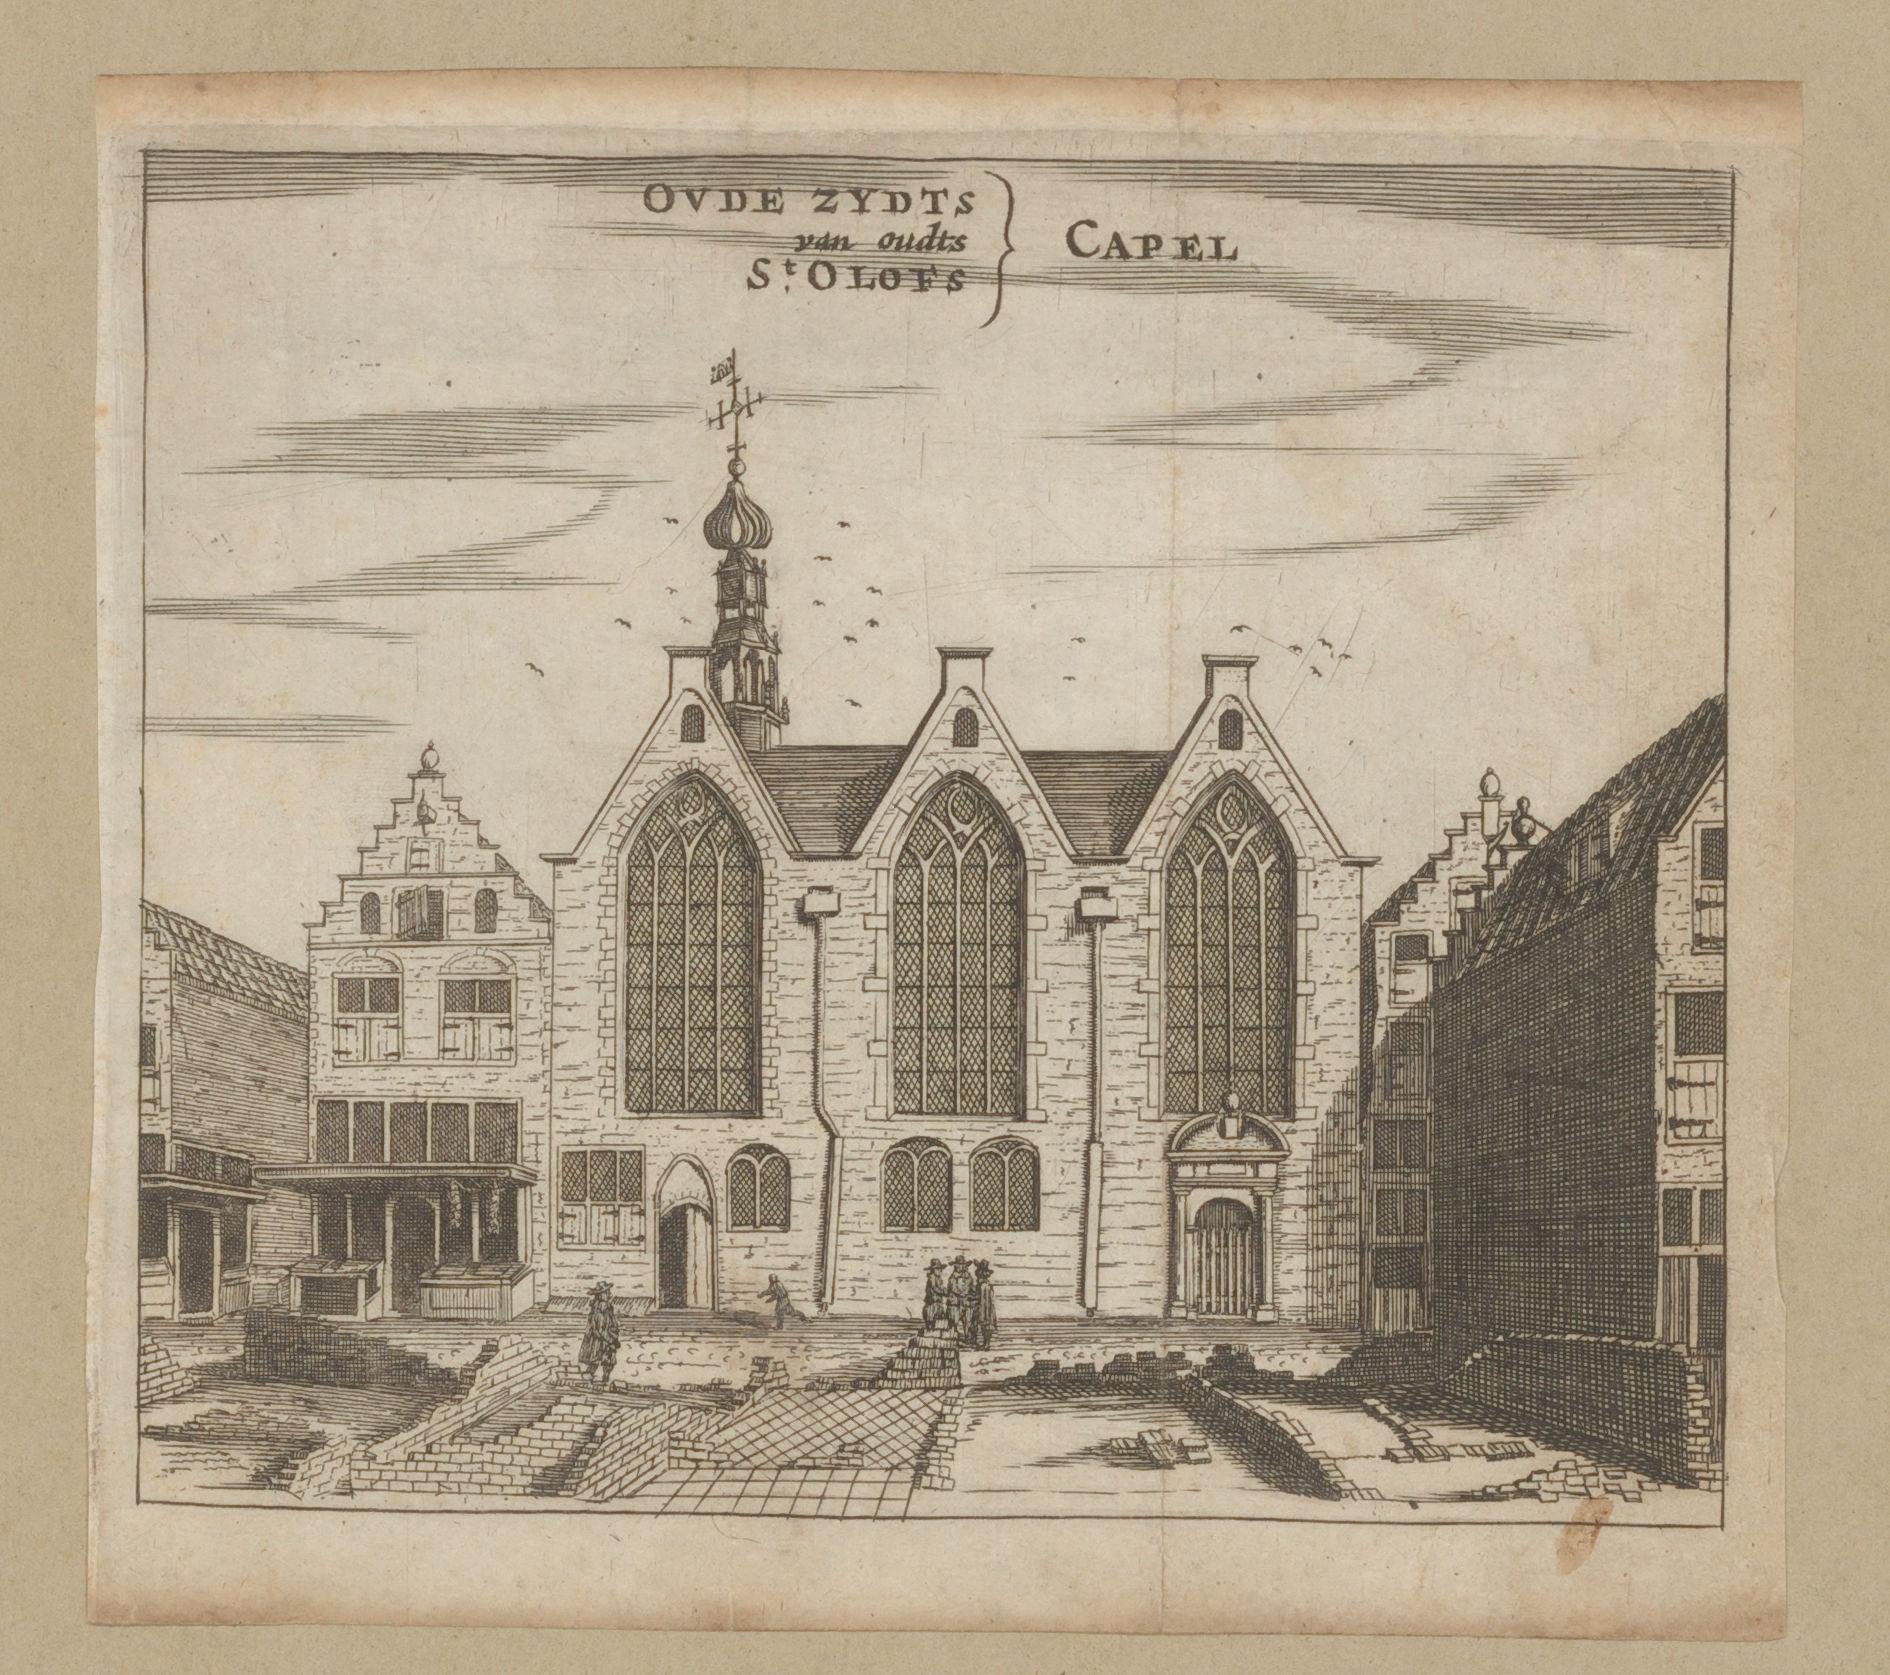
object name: book illustration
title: Oude Zydts van oudts St. Olofs Capel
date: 1664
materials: paper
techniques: engraving, etching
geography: amsterdam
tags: church (exterior) - qq - small church, chapel, street (+ city(-scape) with figures, staffage)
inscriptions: collector's mark: ‘32.3A+B’ Lugt 1641b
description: Huidige staat van prent ook gebruikt in: Fockens, Melchior. Beschrijving Der wijdt-vermaarde Koop-stadt Amstelredam, Van haar eerste beginselen, zedert den Jare 1203. oude Voorrechten, verscheyde Vergrootingenoude Voor-rechten, en verscheyde Vergrootingen (…). 3e druk. Amsterdam: Marcus Willemsz. Doornick, 1664. En in: Zesen, Philipp von. Beschrybung der Weidtberuhmde Kauf-Stadt Amstelredam / Beschreibung der Stadt Amsterdam darinnen von derselben ersten ursprunge bis auf gegenwartigen zustand (…). Amsterdam: Marcus Willemsz. Doornick, 1664. Tweede bekende staat (met toevoeging Franse titel) ook gebruikt in: Domselaer, Tobias en Isaac Commelin. Beschryvinge van Amsterdam : haar eerste oorspronk uyt den huyze der heeren van Aemstel en Aemstellant (…). 6 delen. Amsterdam: Marcus Willemsz van Doornick, 1665. Derde bekende staat (rechtsboven genummerd: 11) ook gebruikt in verschillende latere zeventiende- en achttiende-eeuwse publicaties.